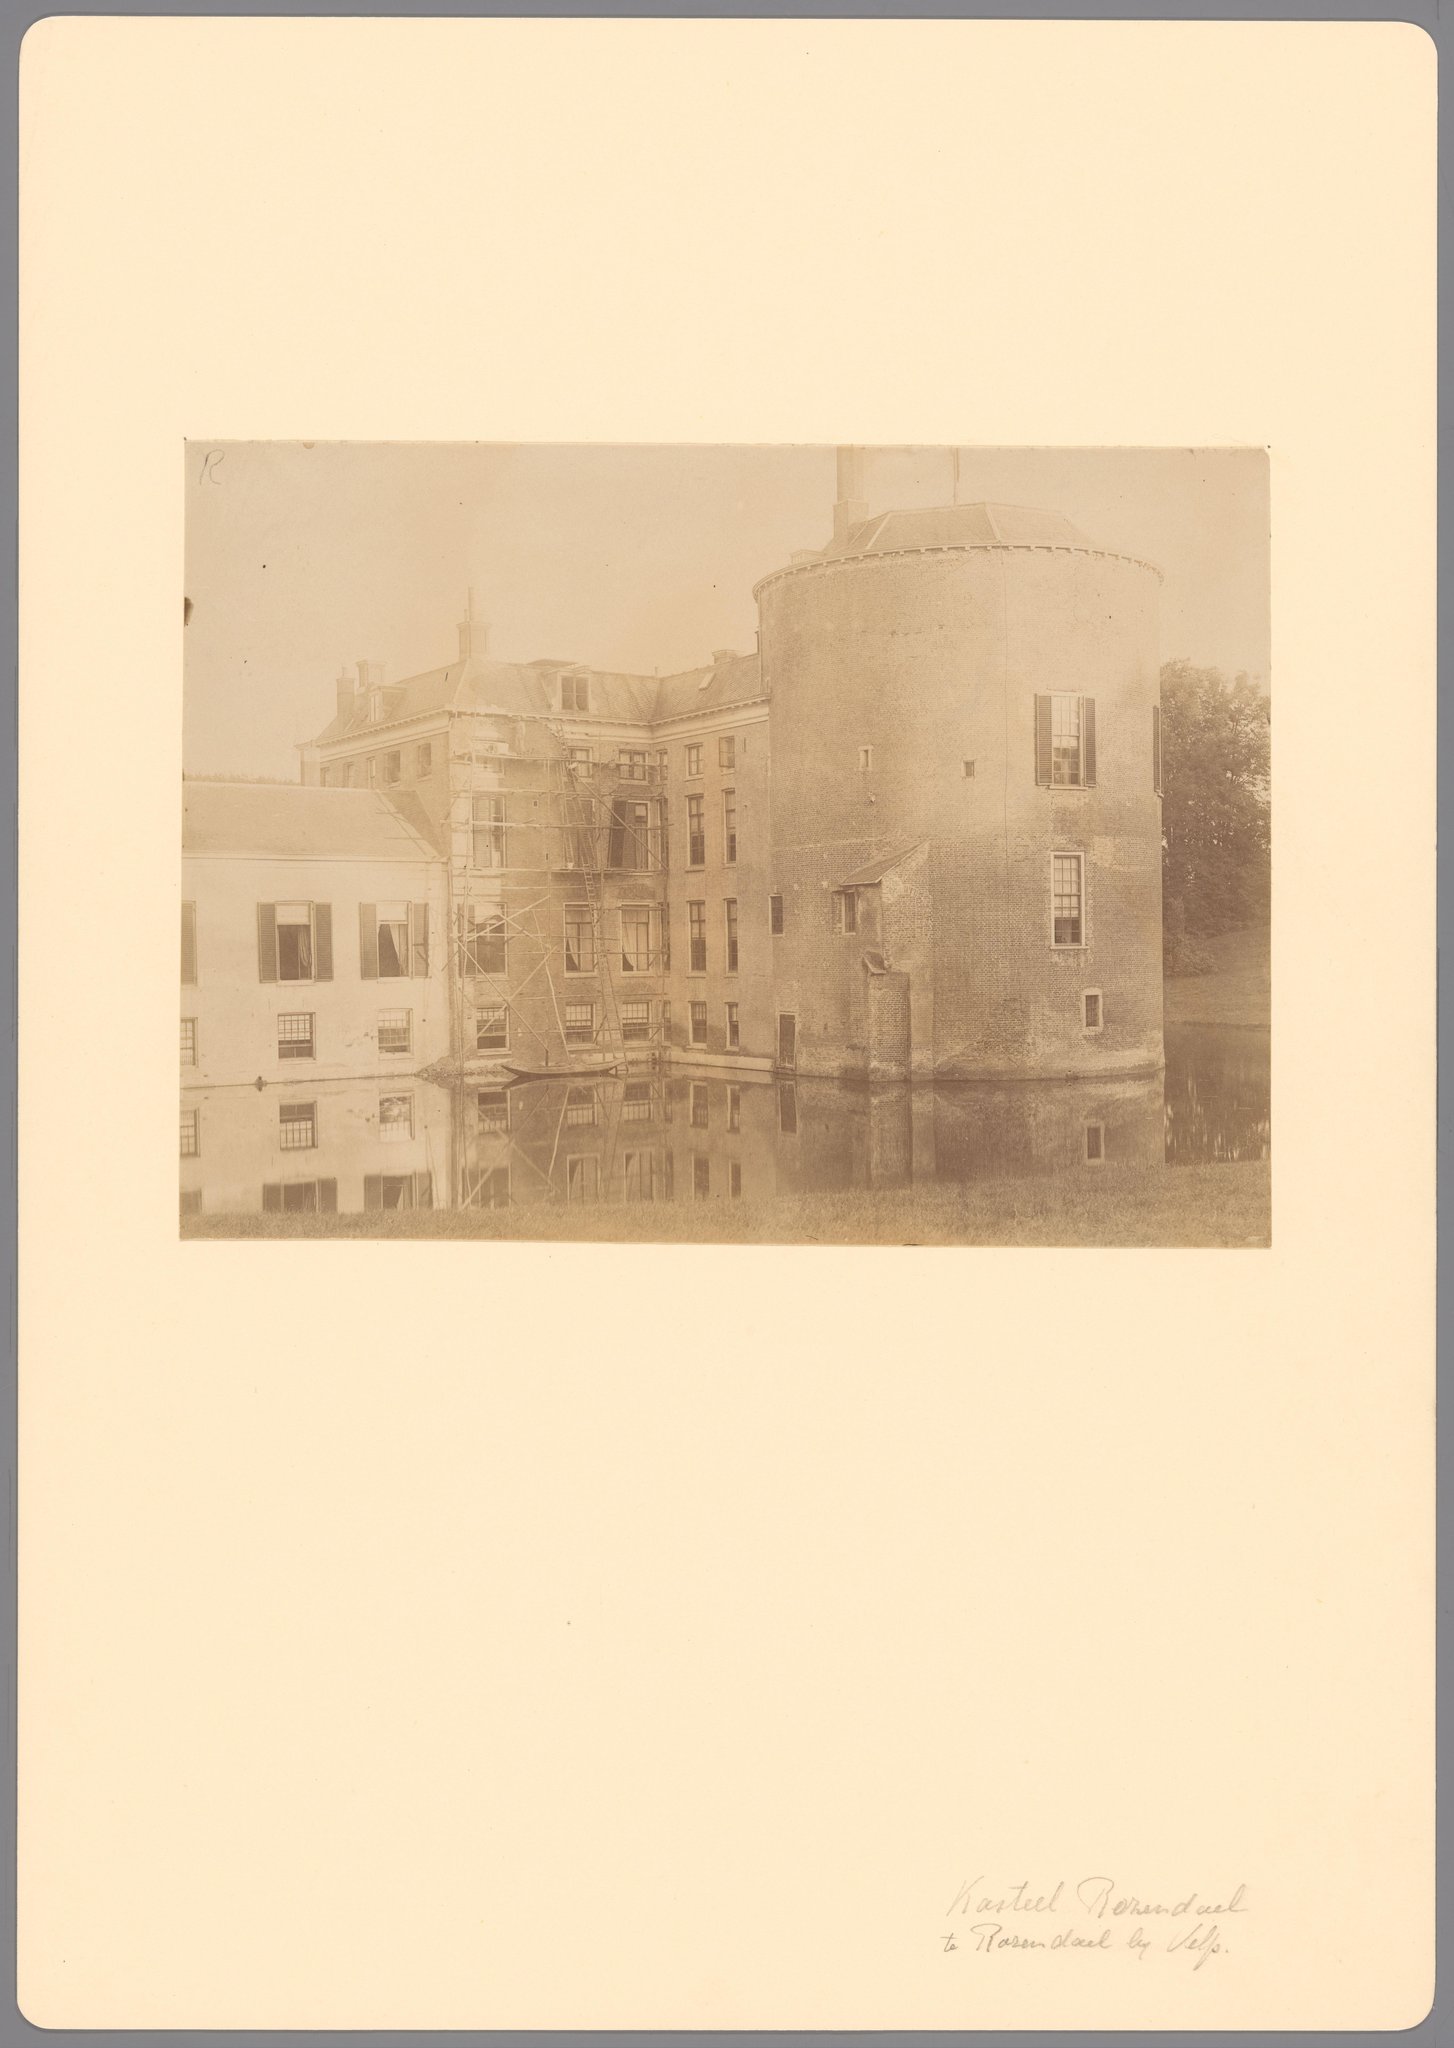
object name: photograph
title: Gezicht op Kasteel Rozendael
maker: anoniem (monumentenzorg)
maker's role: fotograaf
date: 1890-1920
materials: cardboard, photographic support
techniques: albumen print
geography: rozendaal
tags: castle, landscape with tower or castle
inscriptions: annotation: ‘R/ Kasteel Rozendael te Rozendael bij Velp’, annotation: ‘Kasteel Rozendael te Rozendael bij Velp’